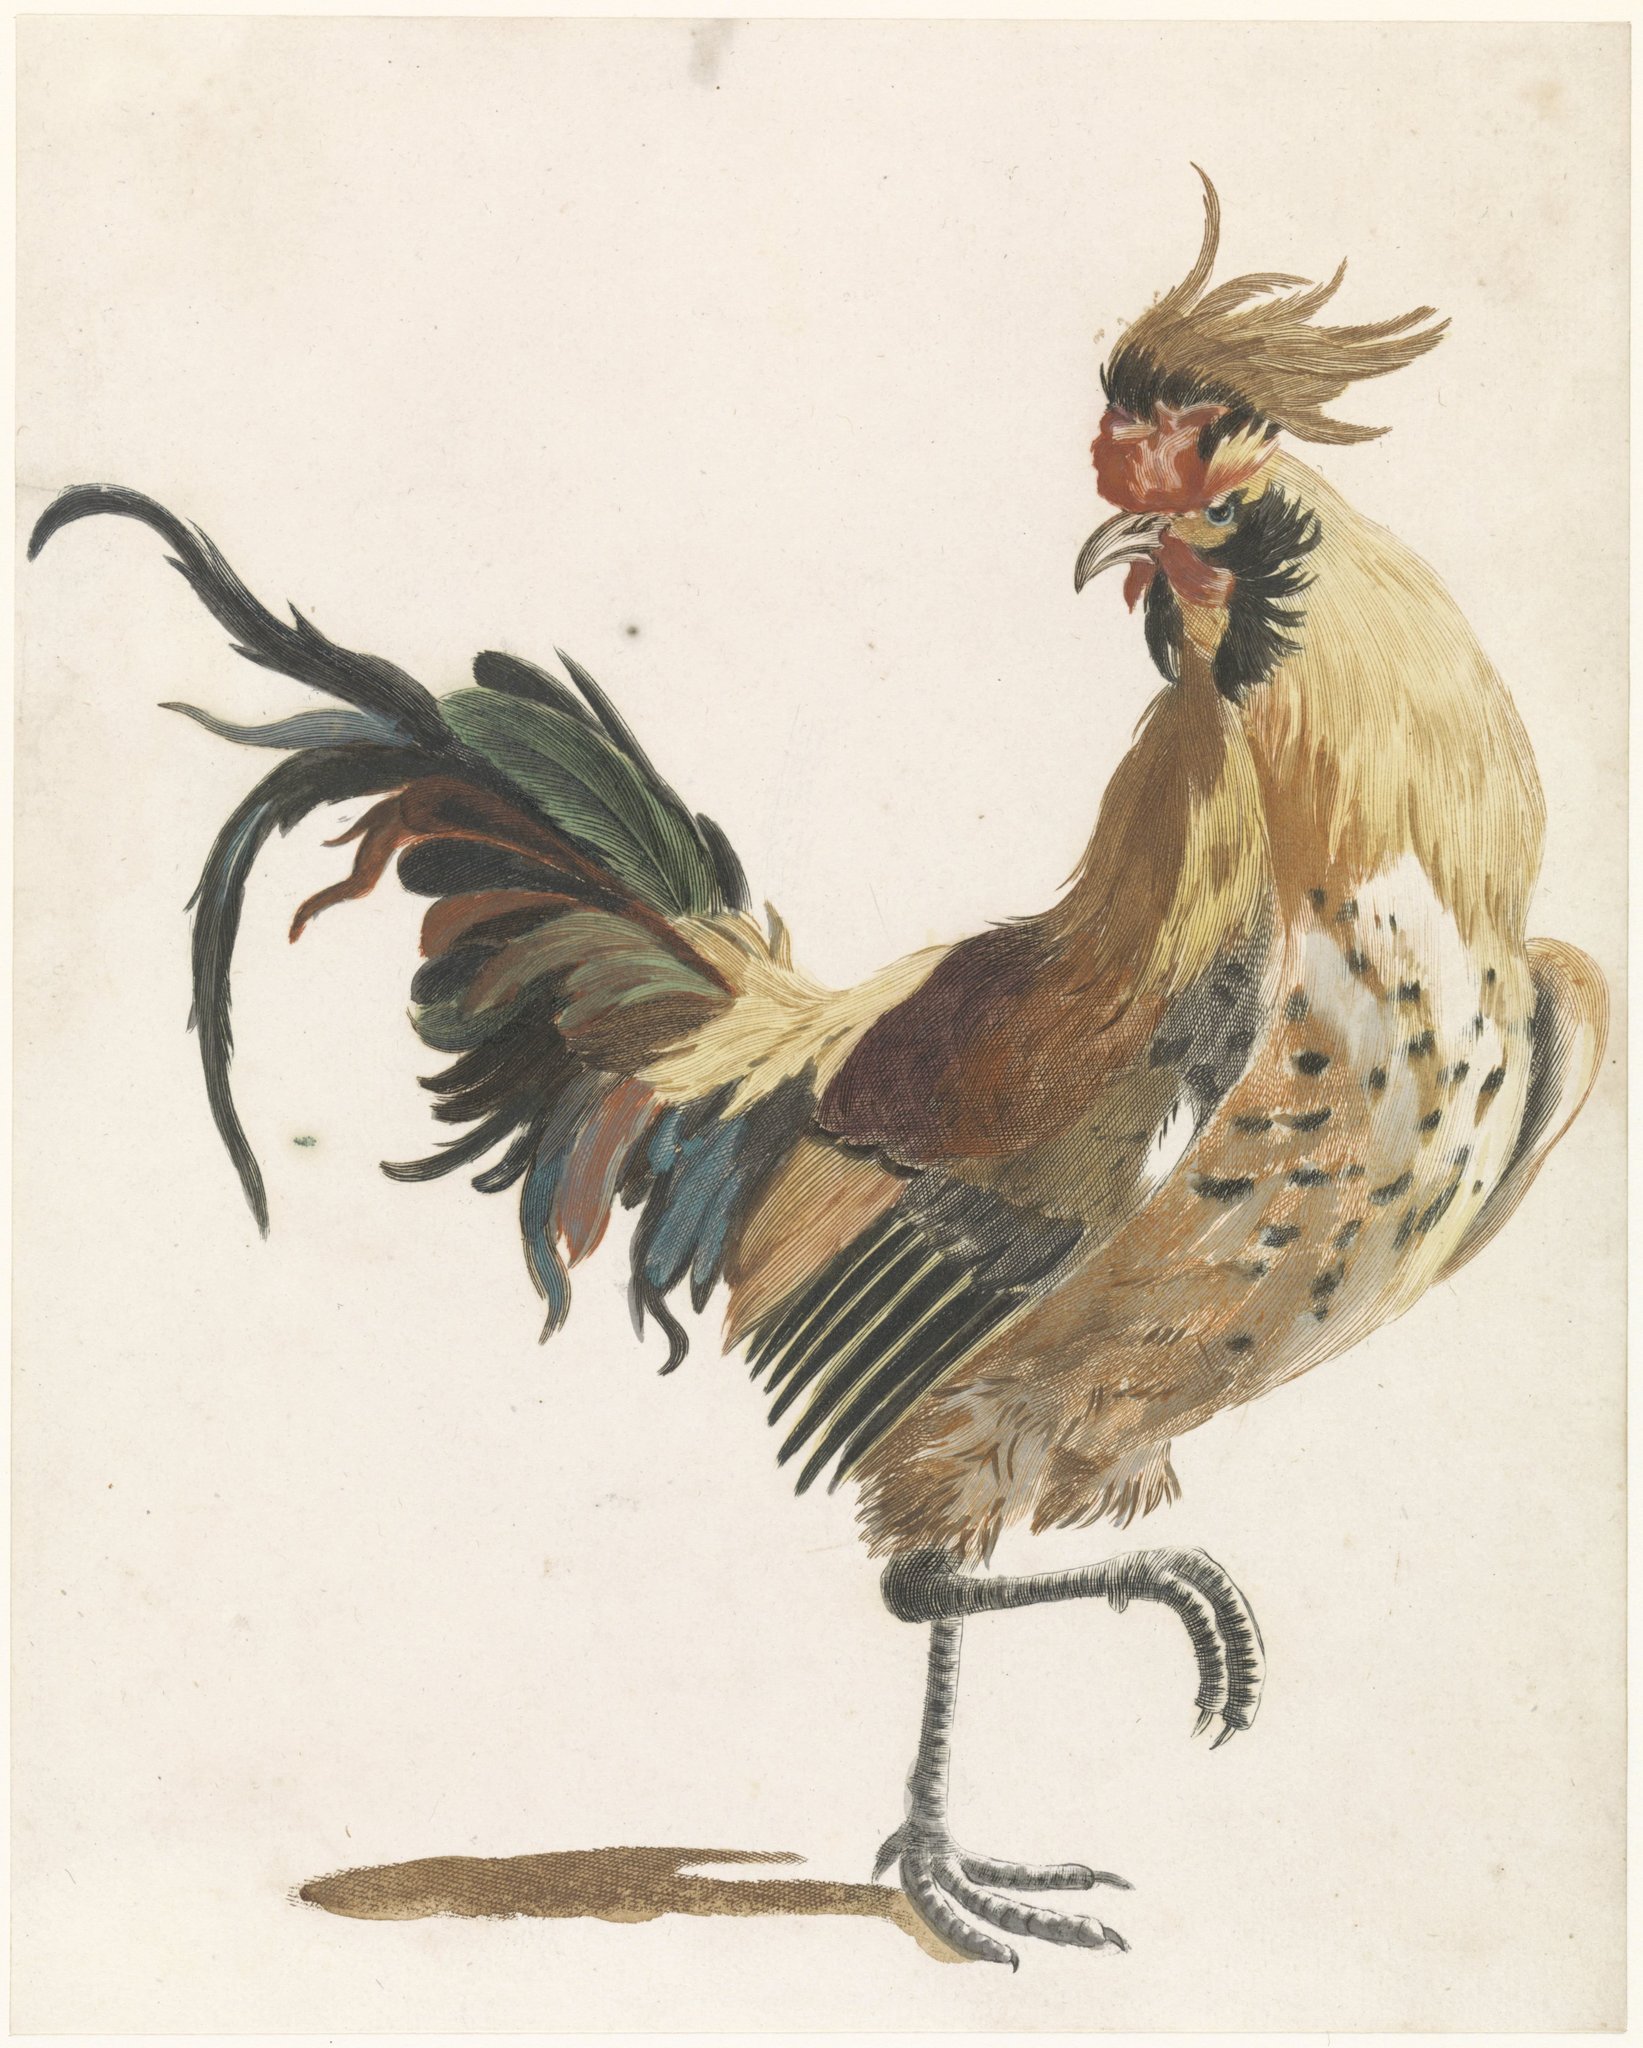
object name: print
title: Haan lopend naar rechts (versie B)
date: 1688-1698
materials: paper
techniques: printing, engraving, hand coloring, lithography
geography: netherlands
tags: fowl (cock, hen, chicken, etc.)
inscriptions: collector's mark: Lugt 2760, collector's mark: Lugt 2228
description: Haan, lopend naar rechts, omkijkend naar links.